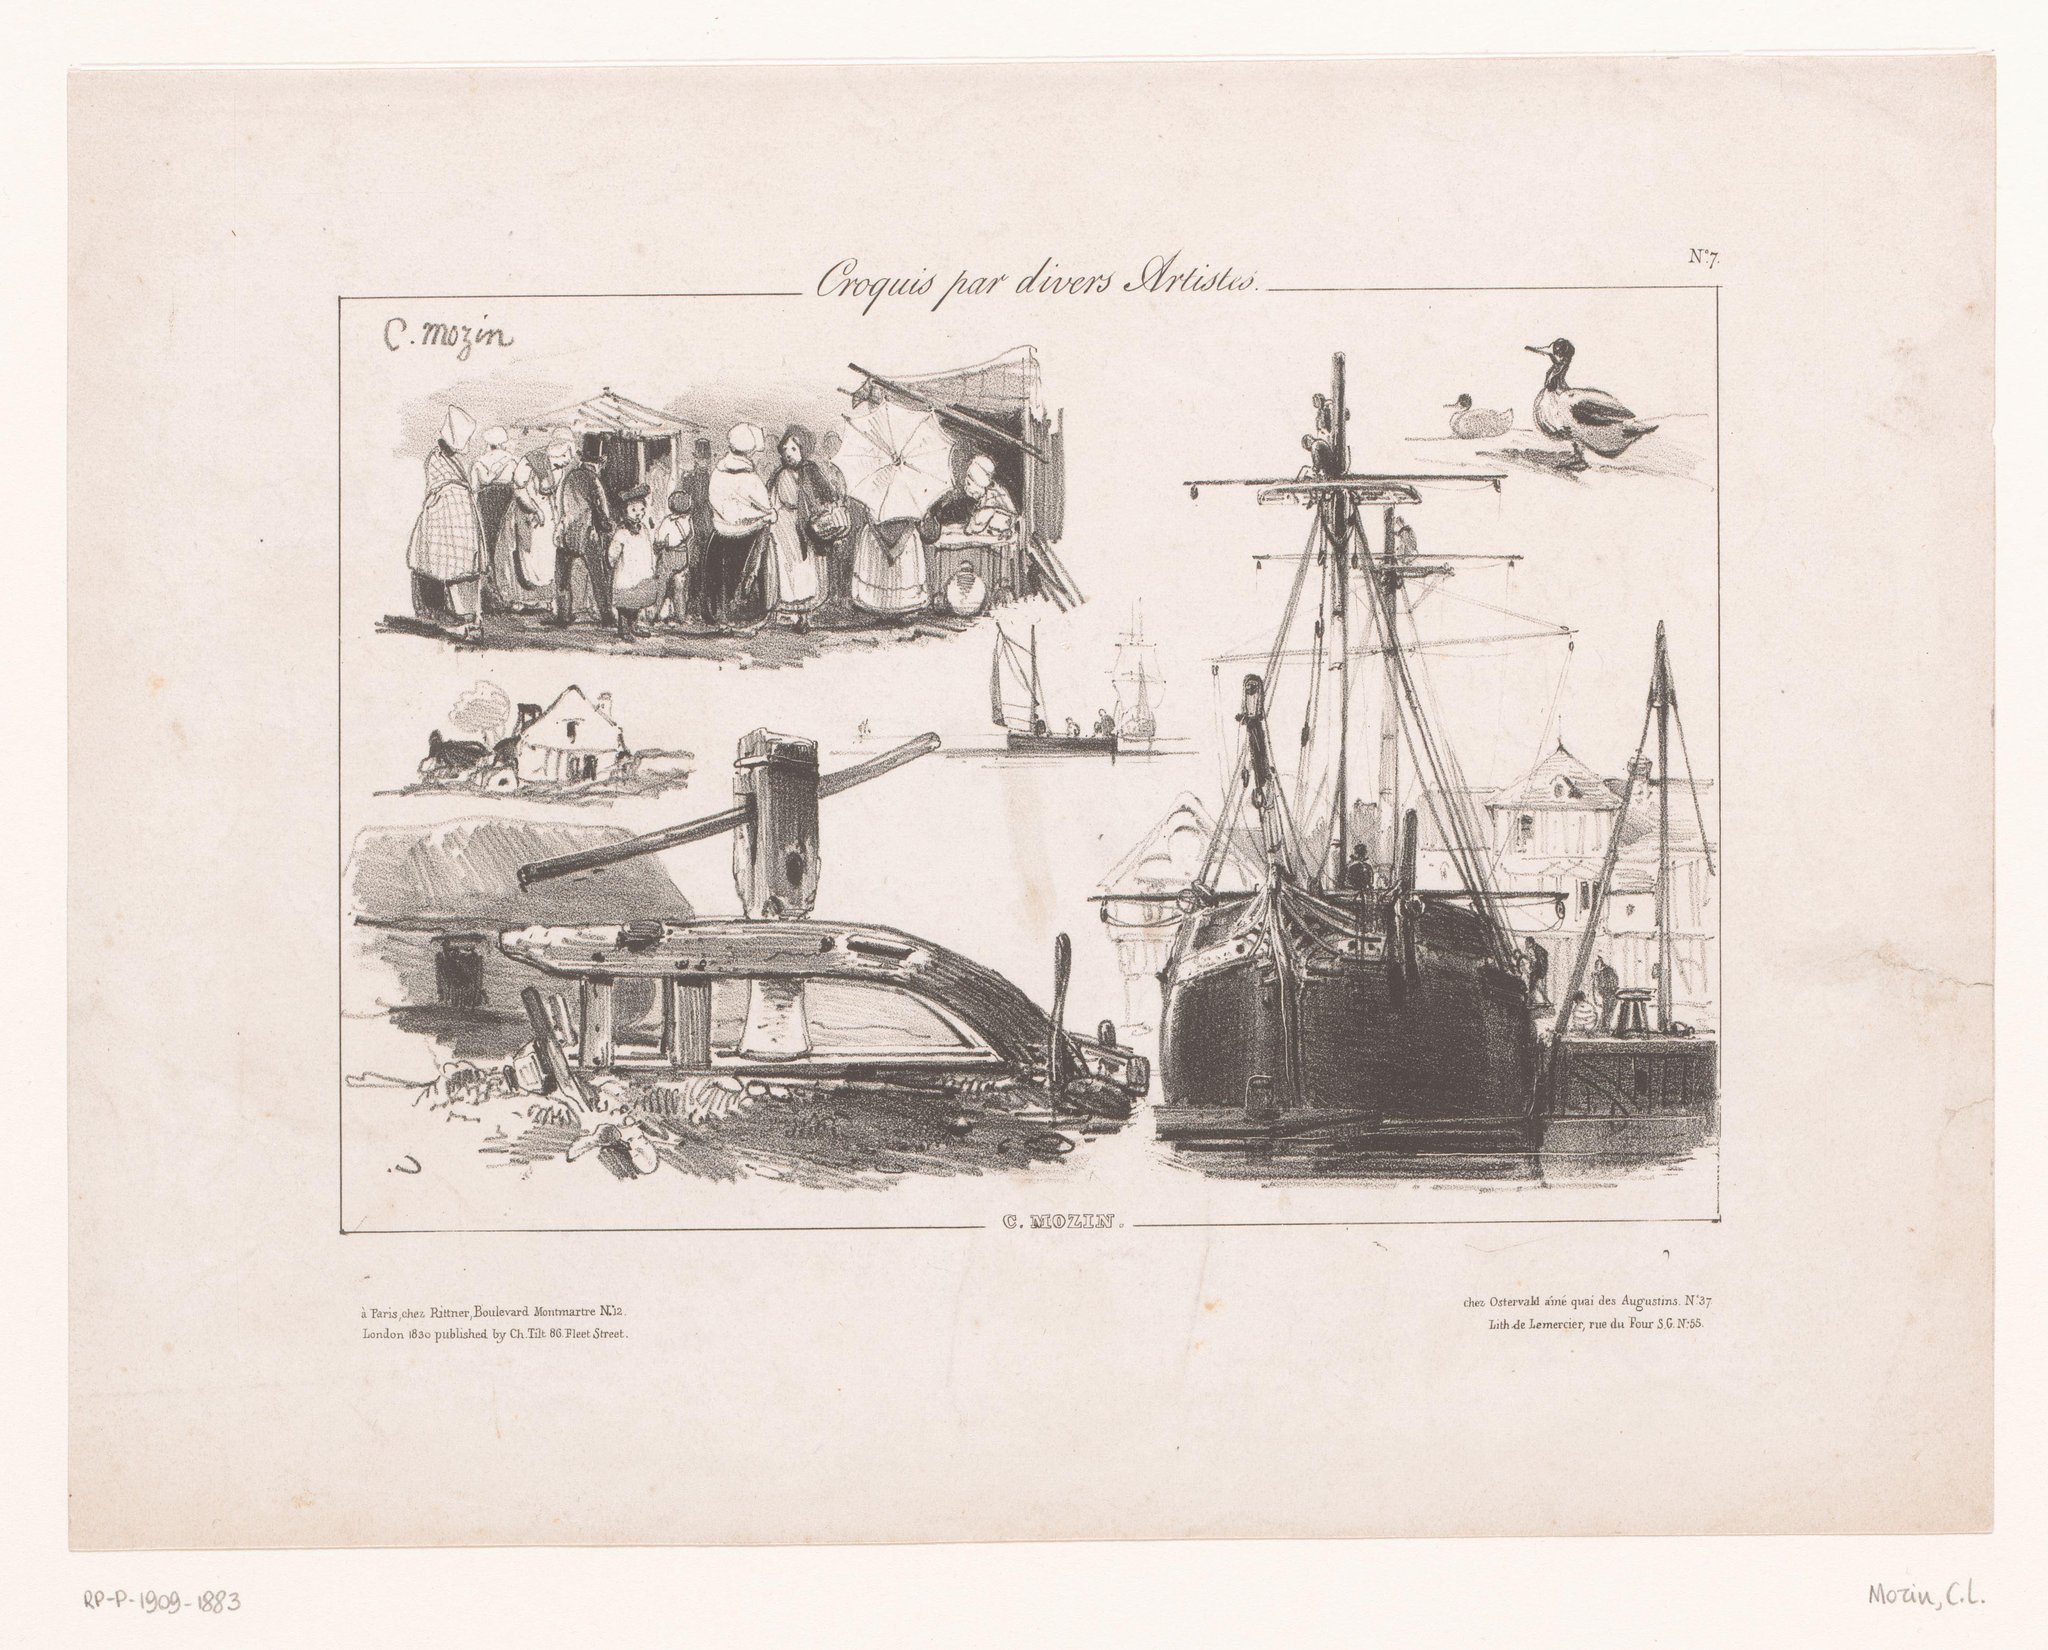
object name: print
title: Verschillende schetsen over het schippersleven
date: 1829-1840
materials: paper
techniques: lithograph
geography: paris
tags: fashion, clothing, sailing-ship, sailing-boat, ducks (domestic waterbirds)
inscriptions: collector's mark: Lugt 2228